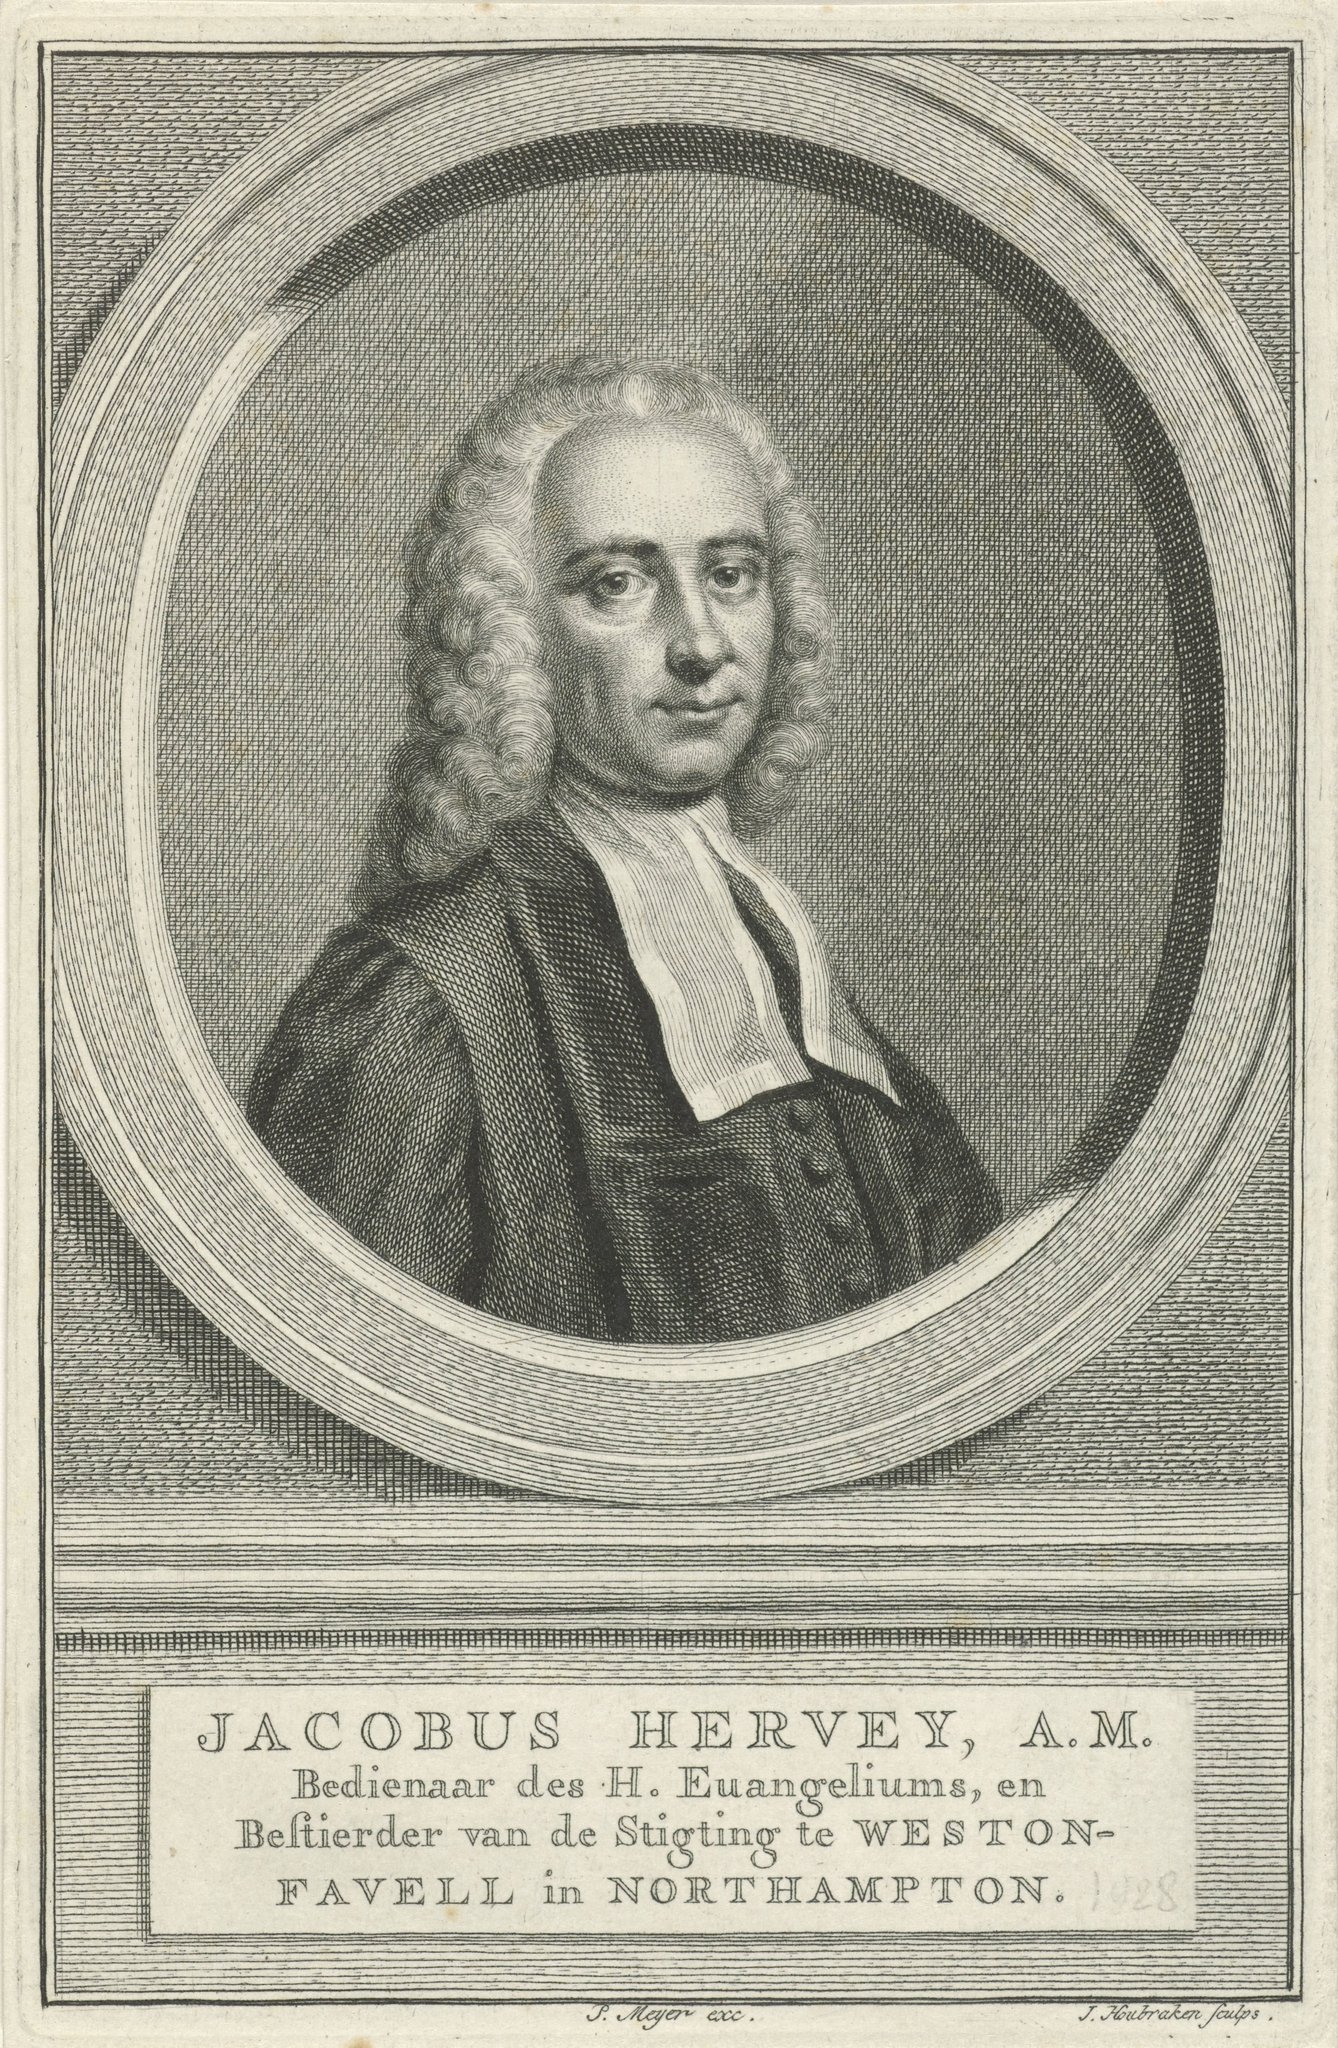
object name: print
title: Portret van Jakobus Hervey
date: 1747-1780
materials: paper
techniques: engraving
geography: amsterdam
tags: schrijver, jakobus hervey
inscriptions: collector's mark: Lugt 240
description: Buste naar rechts van Jakobus Hervey in een ovaal. Het portret rust op een plint waarop zijn naam en gegevens in vier regels in het Nederlands.